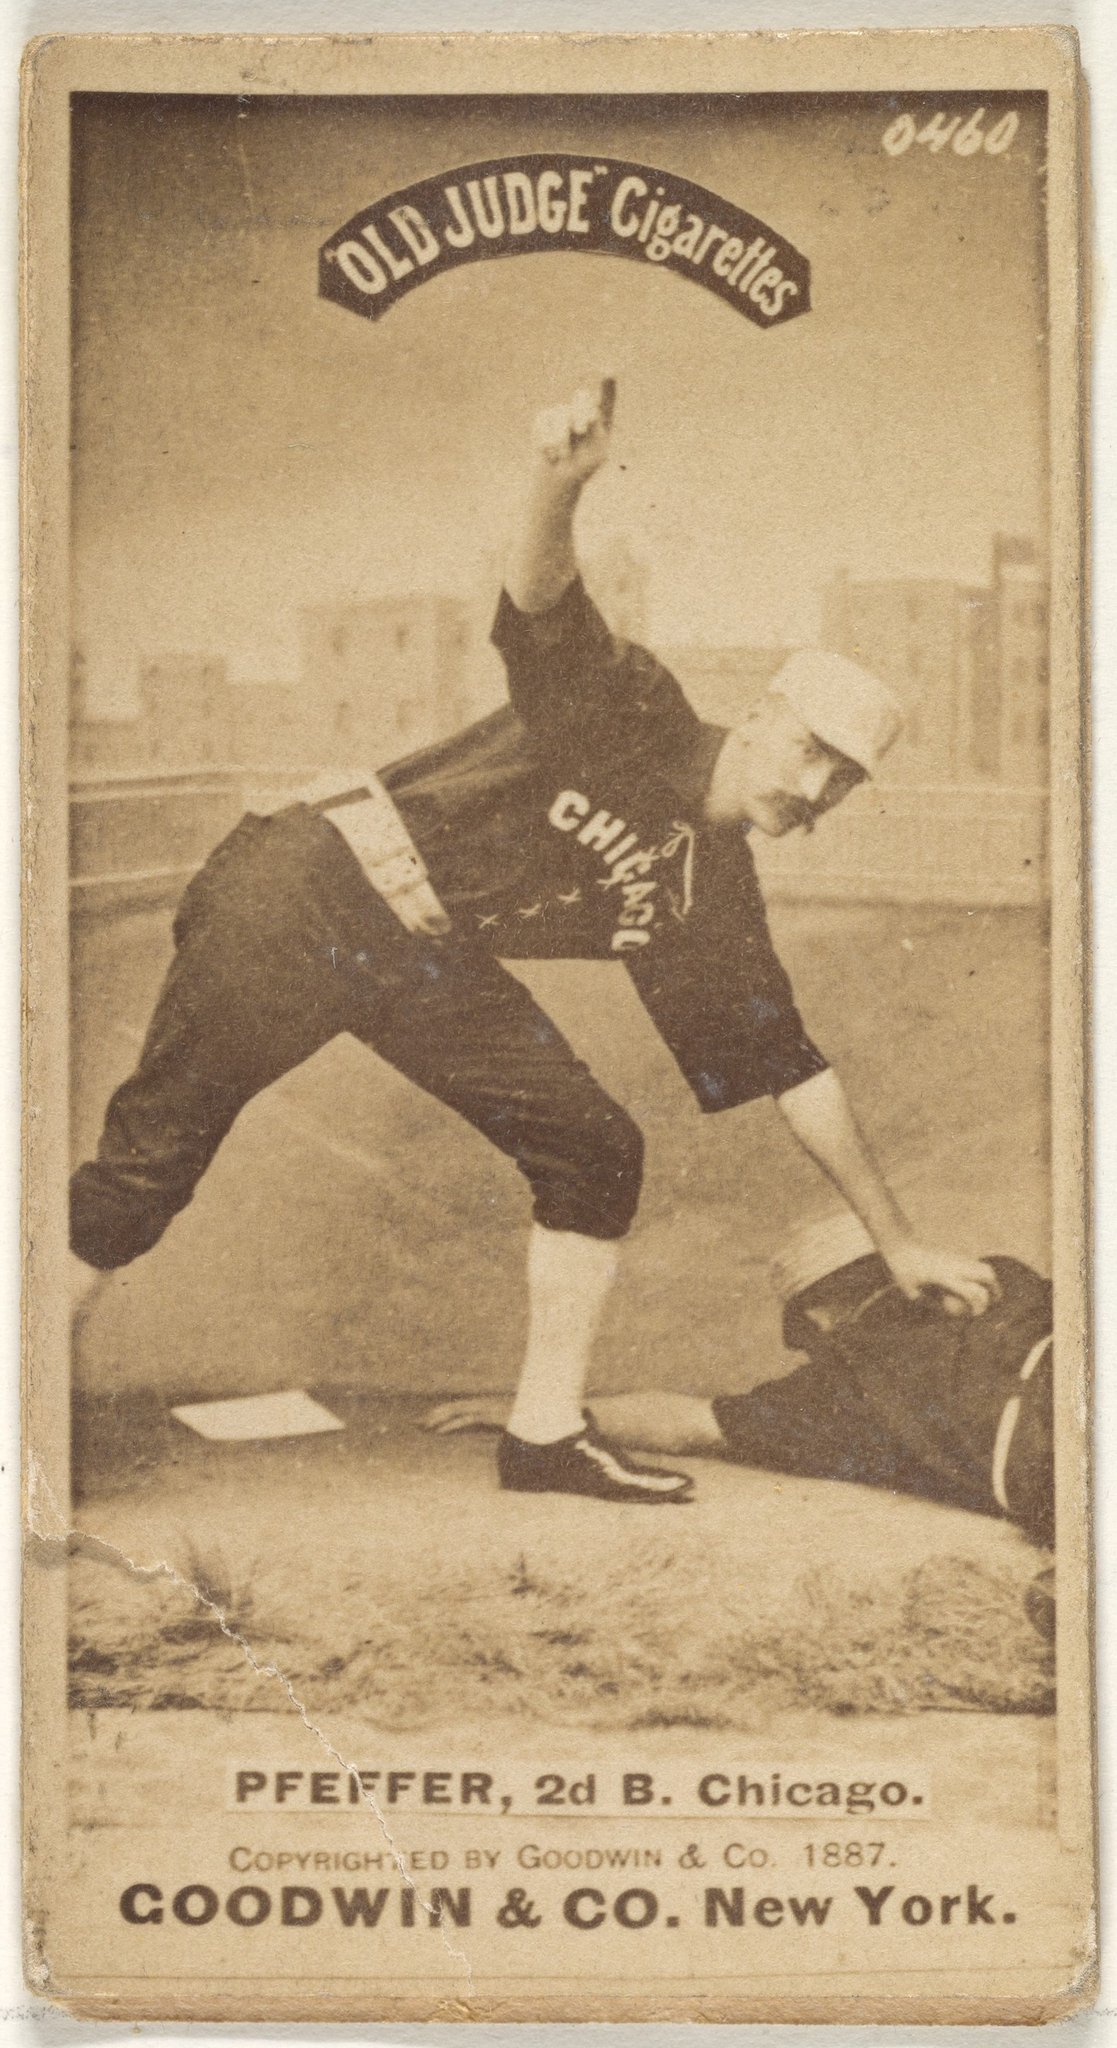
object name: baseball card, photograph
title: Fred "Dandelion" Pfeffer, 2nd Base, Chicago, from the Old Judge series (N172) for Old Judge Cigarettes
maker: goodwin & company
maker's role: publisher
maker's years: 1850-1950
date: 1887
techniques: albumen silver print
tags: men,portraits,baseball,athletes